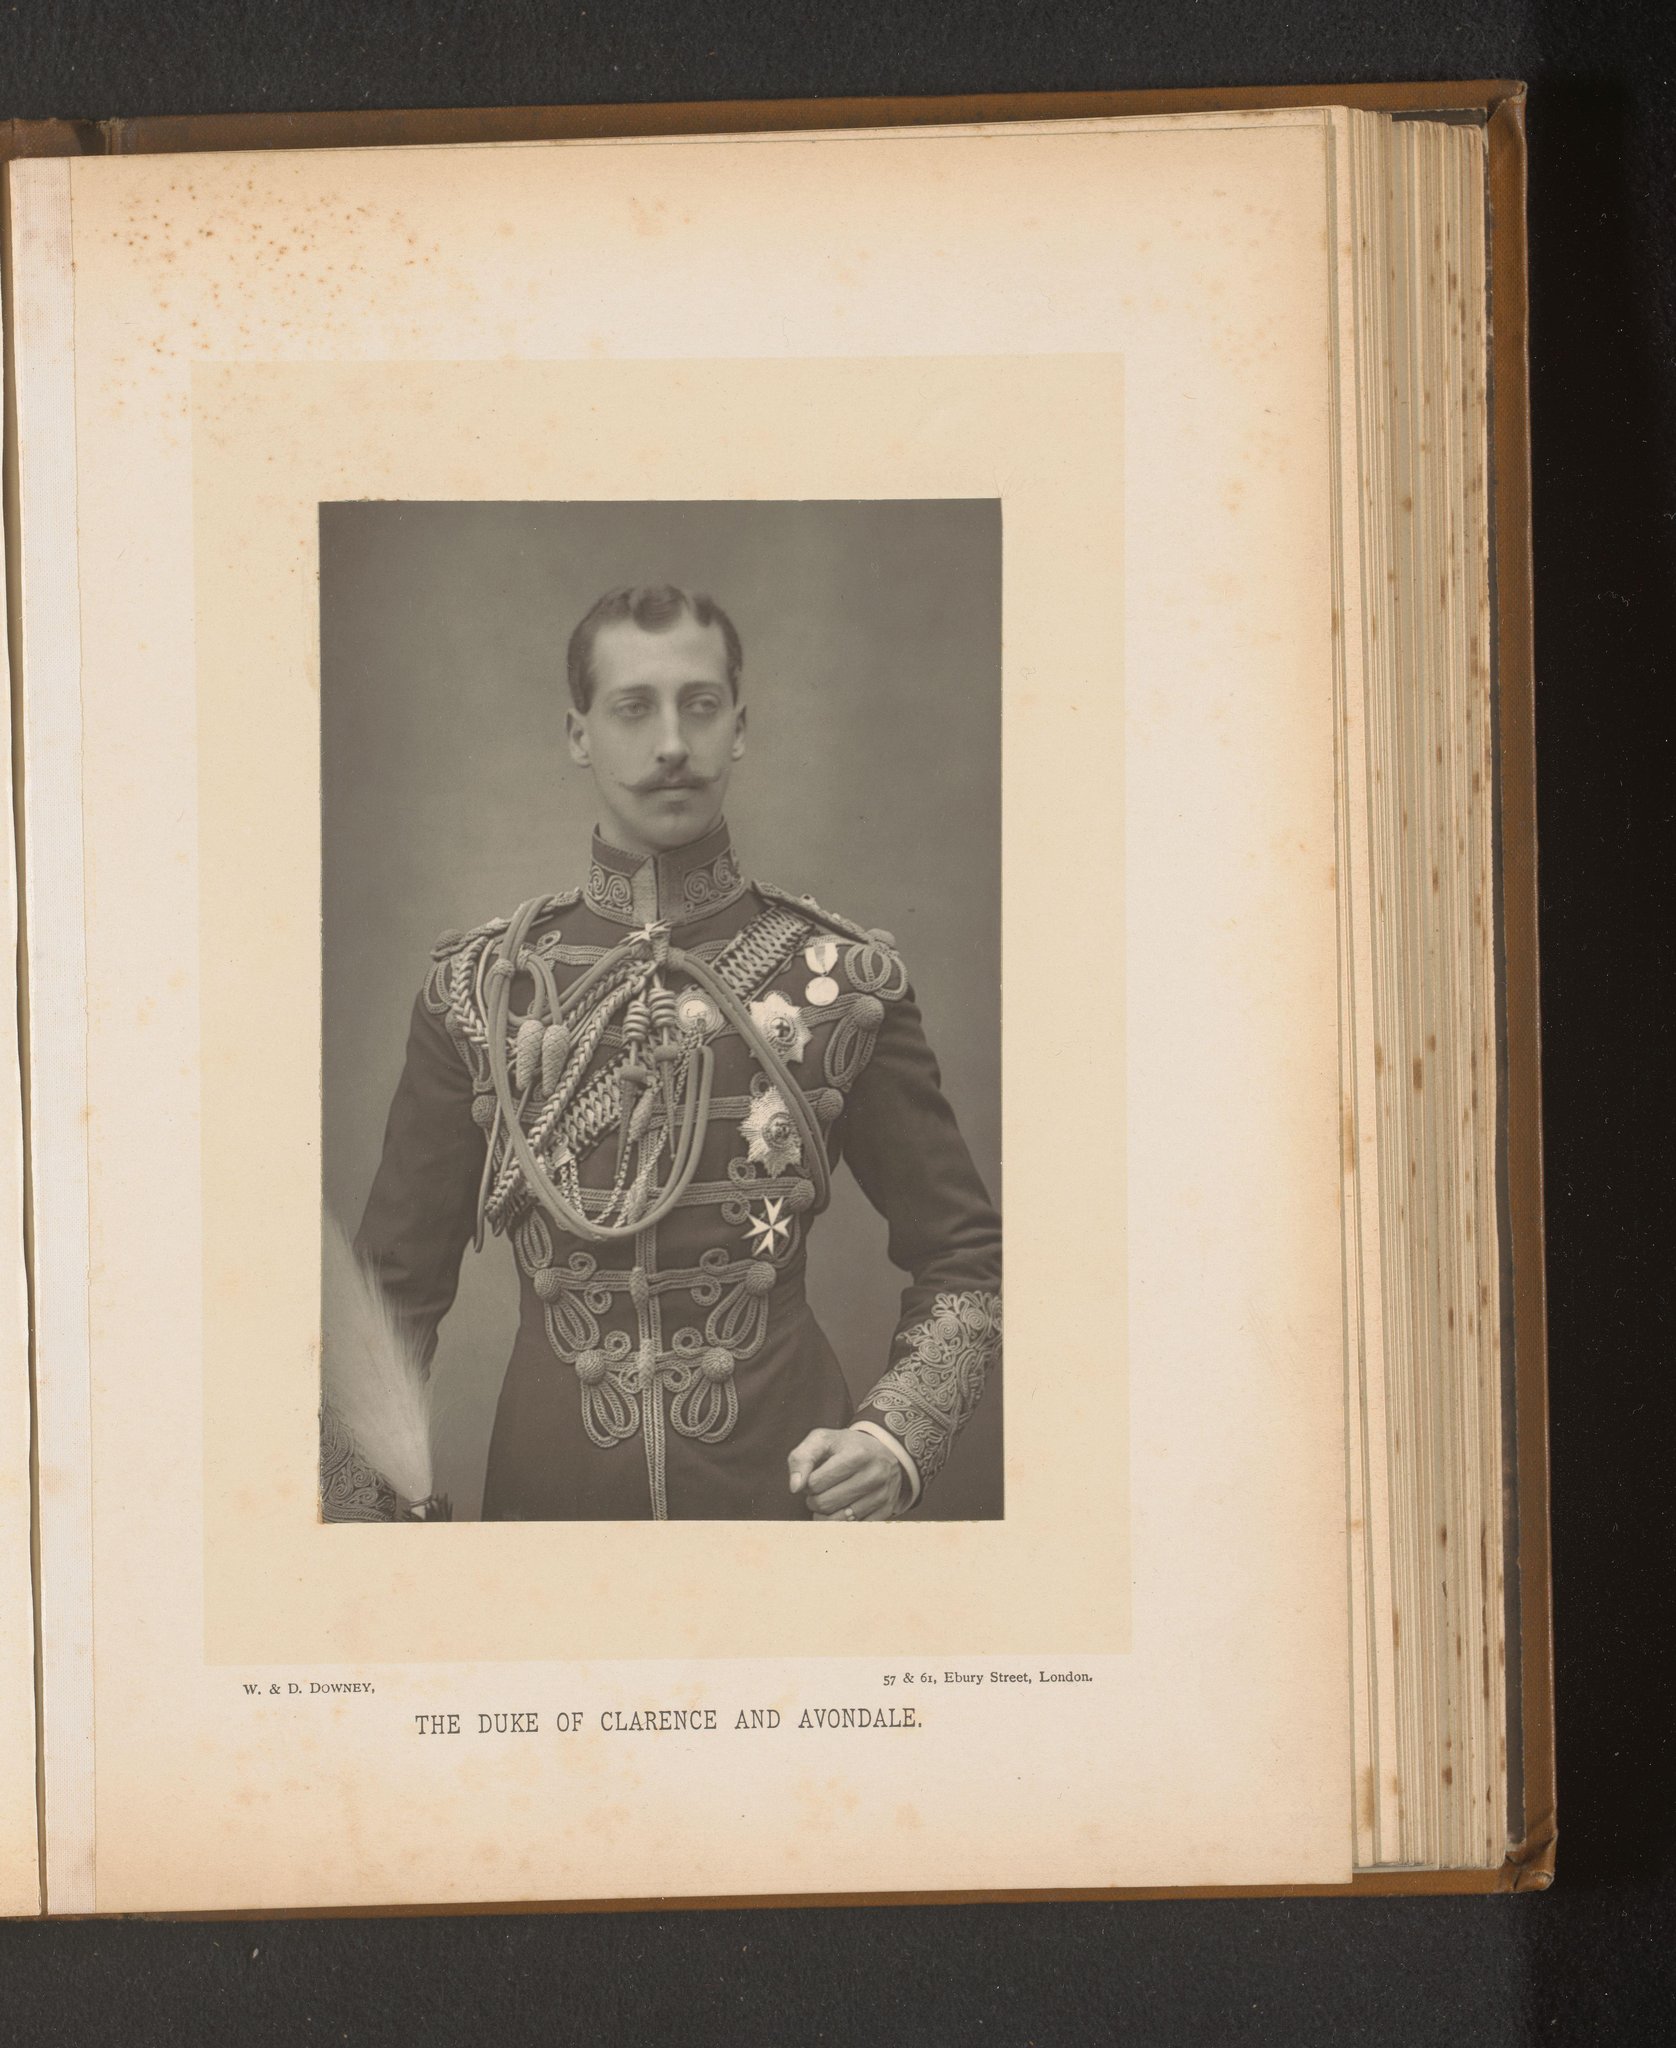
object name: photomechanical print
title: The duke of Clarence and Avondale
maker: Anonymous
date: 1881-1891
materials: paper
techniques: woodburytype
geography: london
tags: ruler, sovereign, (military) uniforms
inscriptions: inscription: ‘57 & 61, Elbury Street, London.’